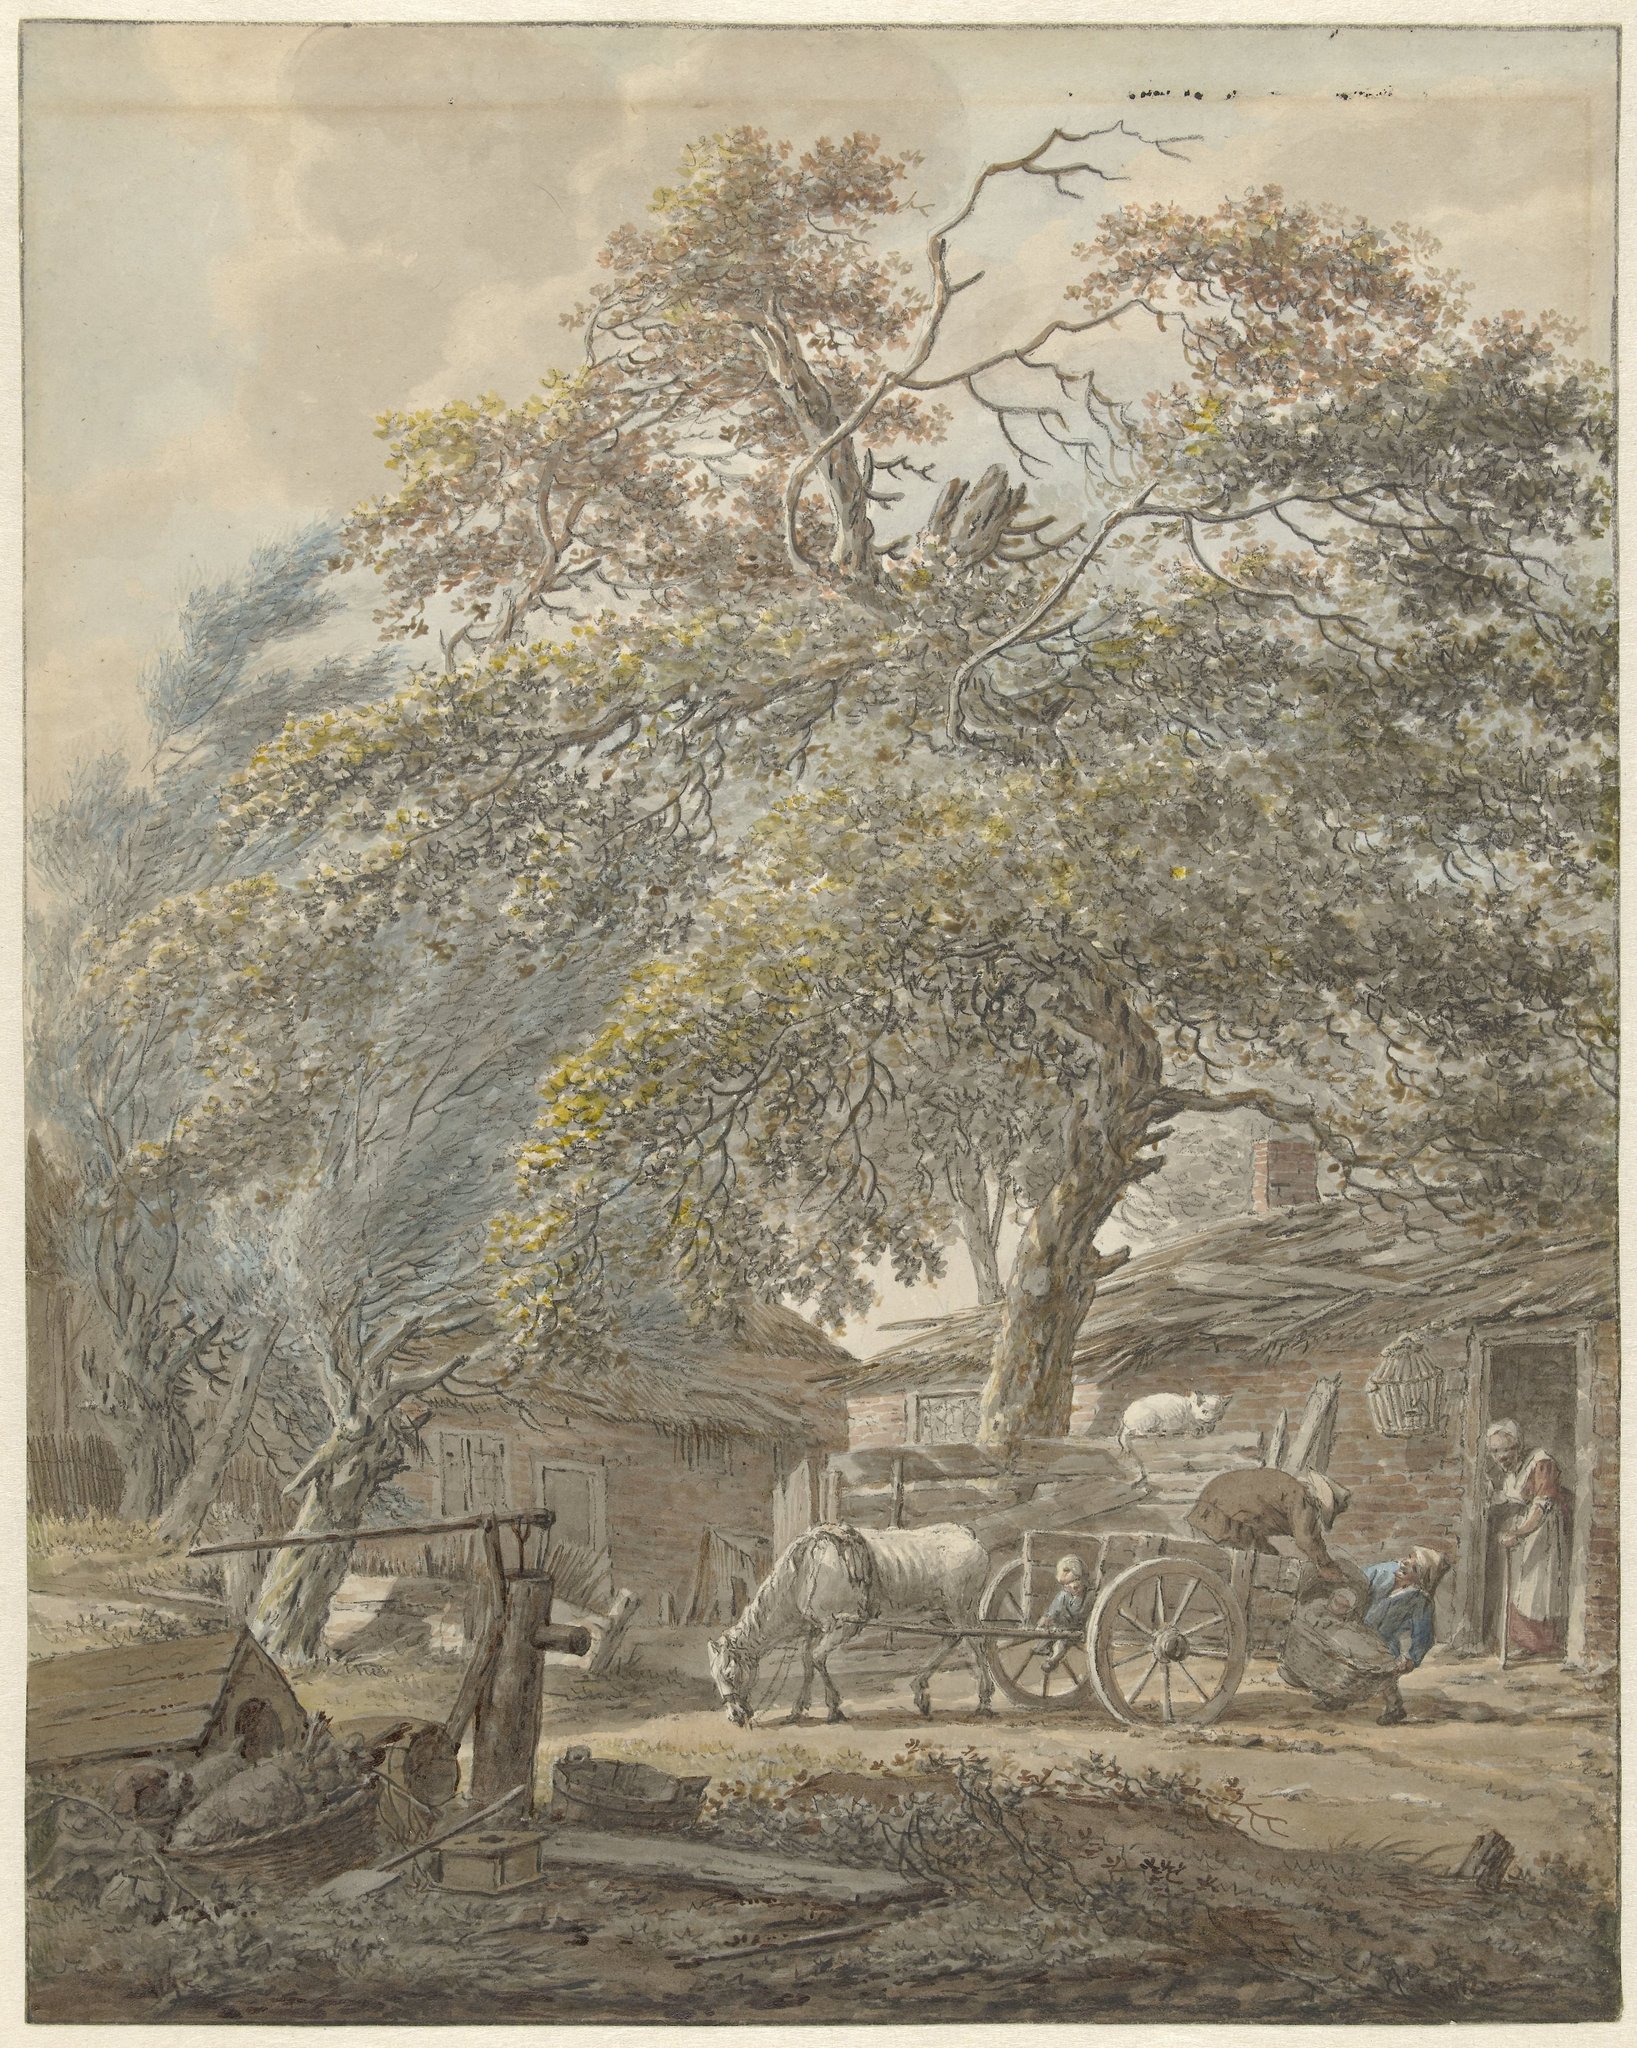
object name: watercolor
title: Boerenerf met twee mannen die een wieg op een paardenkar laden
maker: vincent jansz. van der vinne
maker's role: draughtsman, print maker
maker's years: 1736-1811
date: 1746-1811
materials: chalk, paper, watercolor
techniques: brush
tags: cradle, crib, two-wheeled vehicle drawn by one animal, farm (building)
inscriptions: inscription: ‘Vincent Vander Vinne’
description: Een boerenerf; twee mannen laden een wieg met een kind op een tweewielige paardenkar.